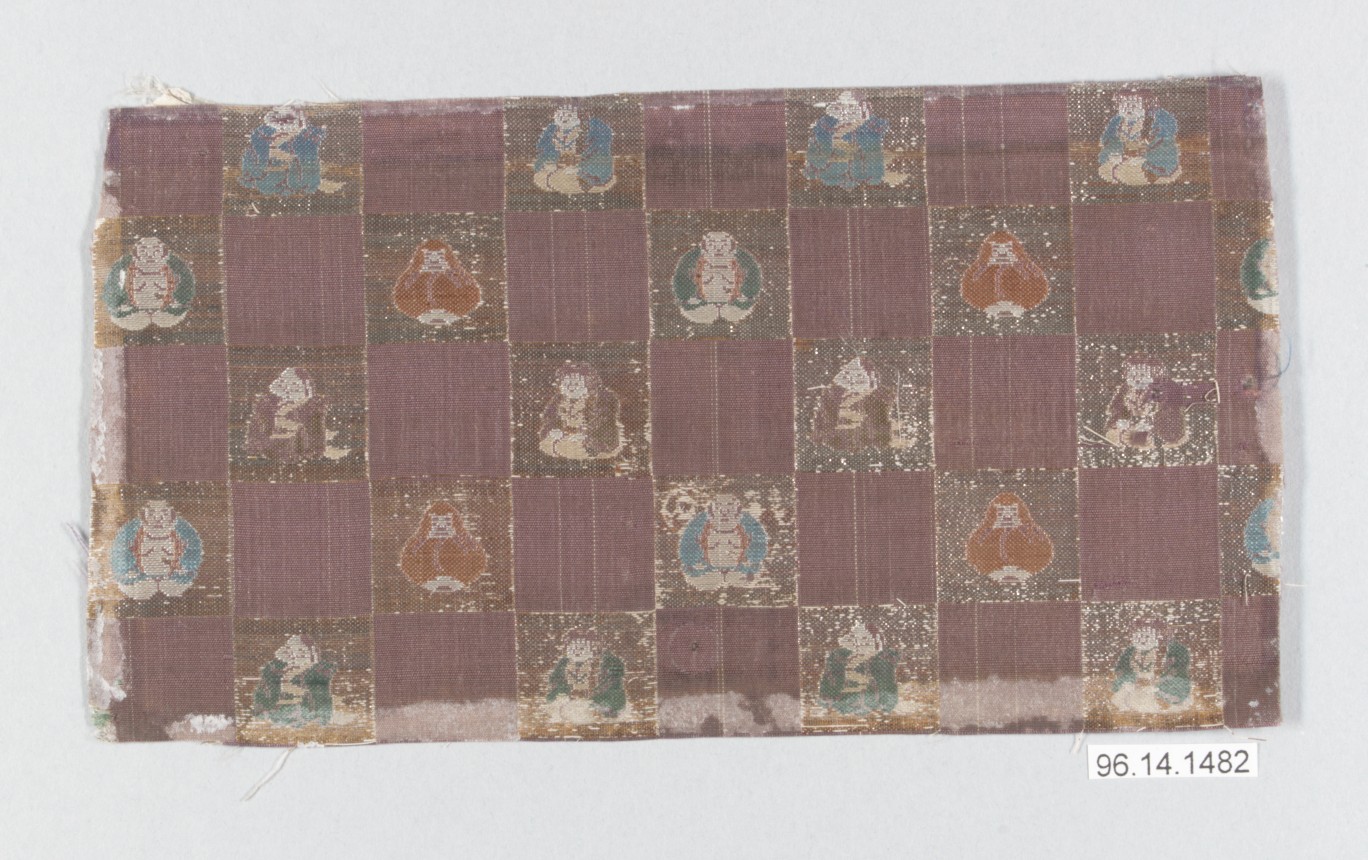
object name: piece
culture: japanese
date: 1701-1800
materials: metal thread, silk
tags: human figures